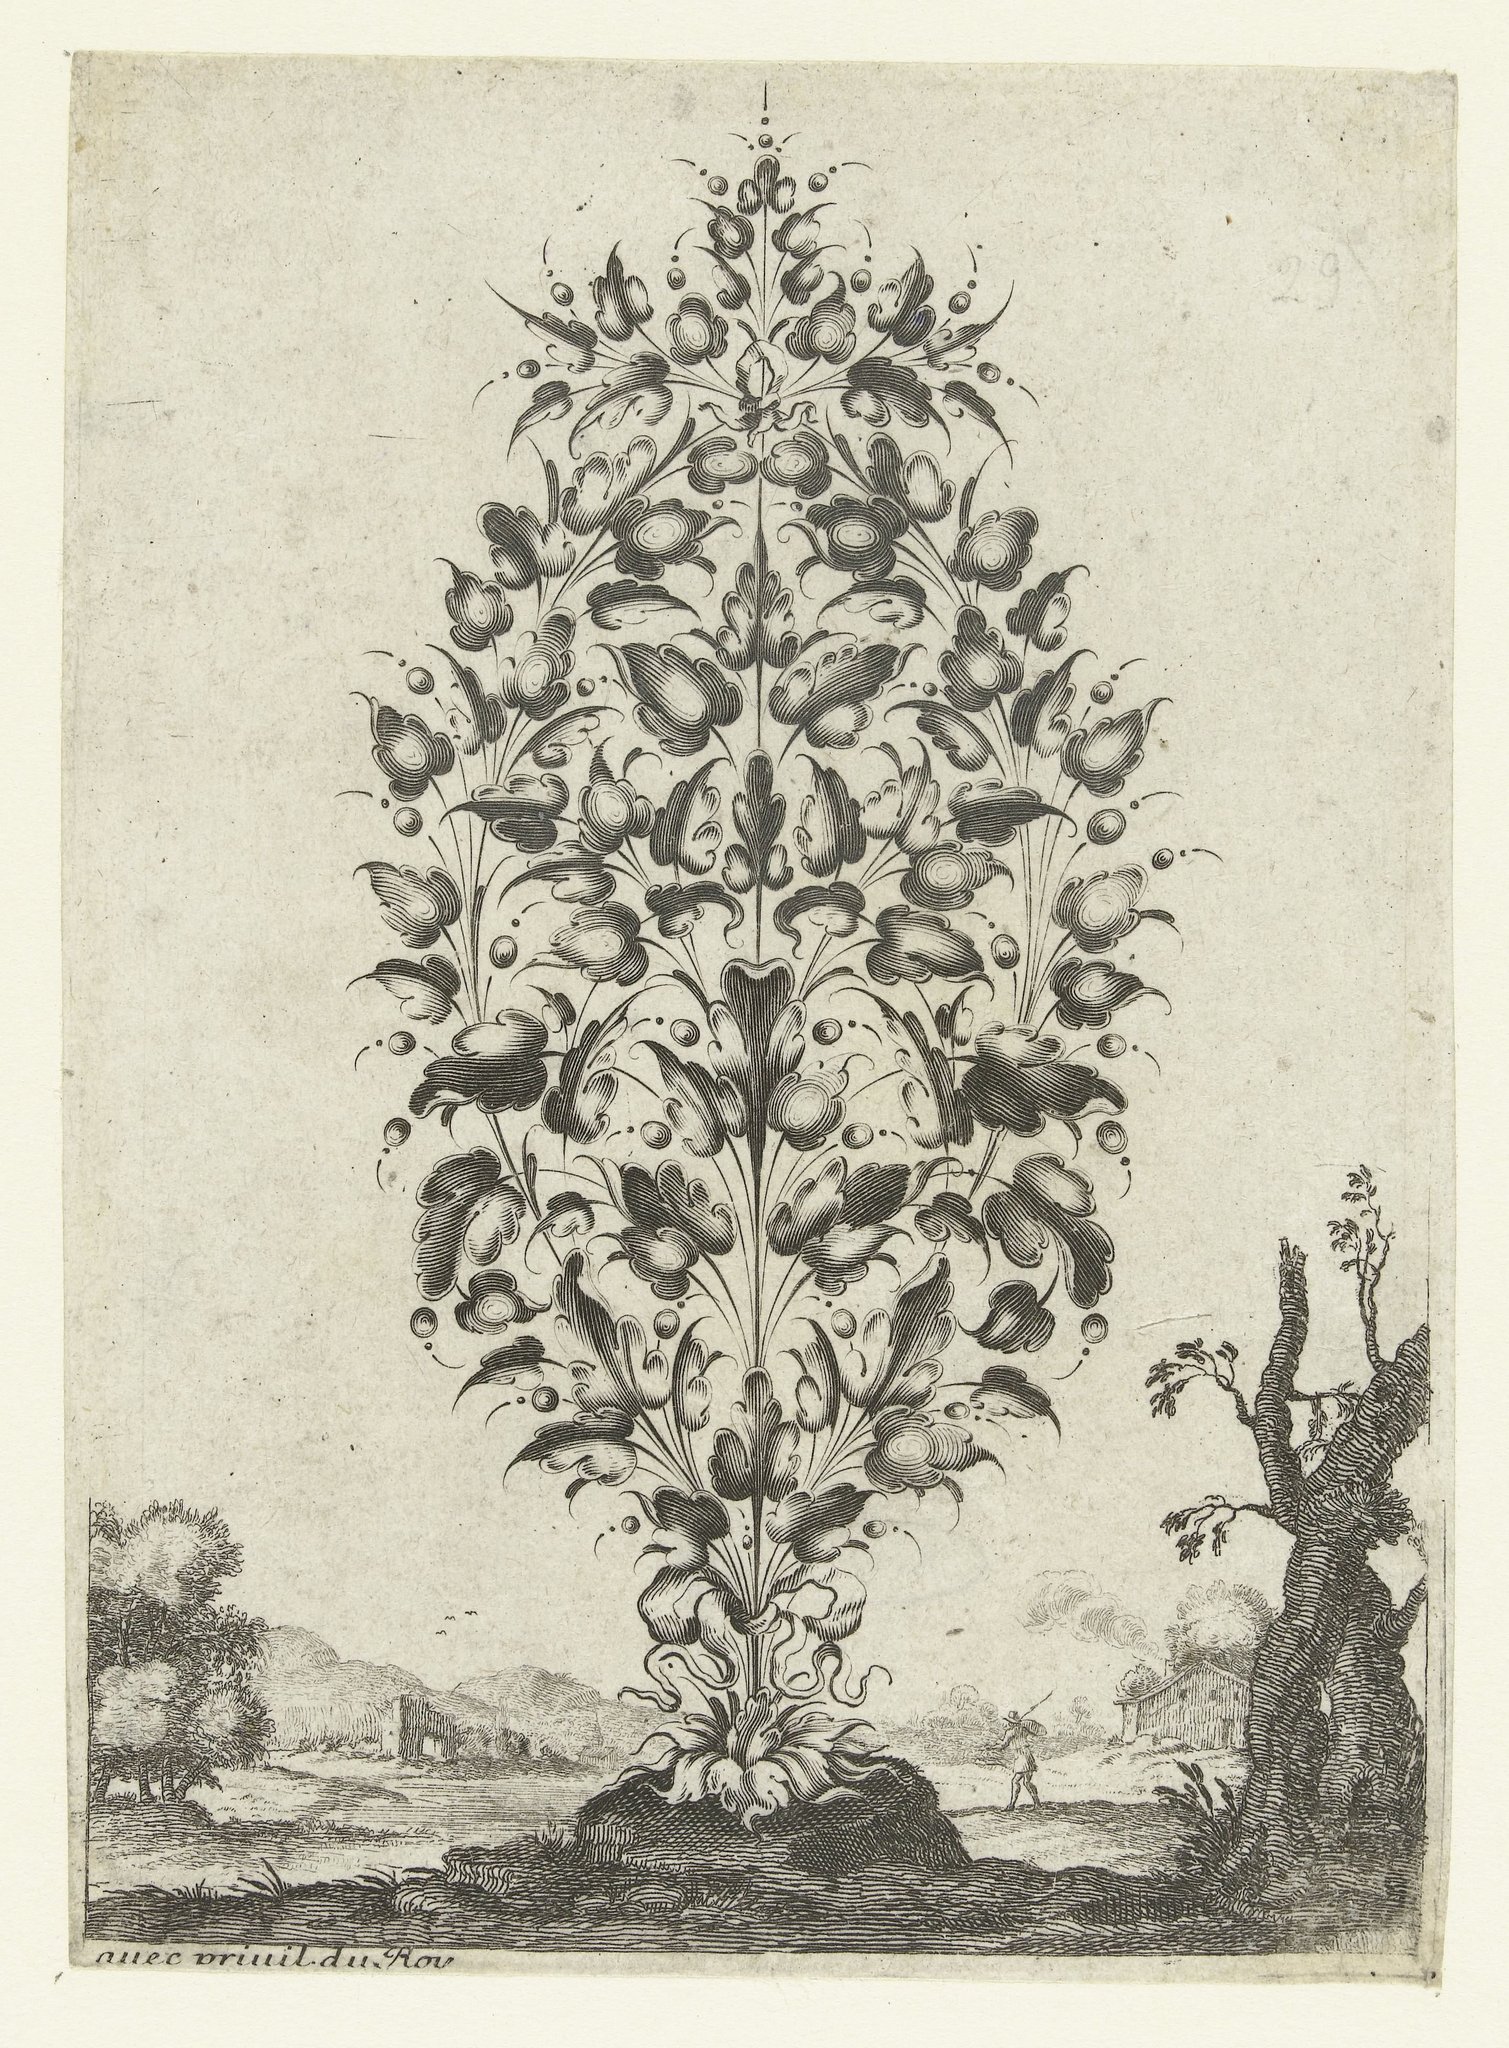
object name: print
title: Liure de Feuilles d'Orfeurerie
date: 1640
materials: paper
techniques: engraving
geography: paris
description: Boeket van drie ranken met bladeren die elkaar bovenaan kruisen. Uit serie van 7 bladen met edelsmidsboeketten met een landschap op de achtergrond. Eerste editie.